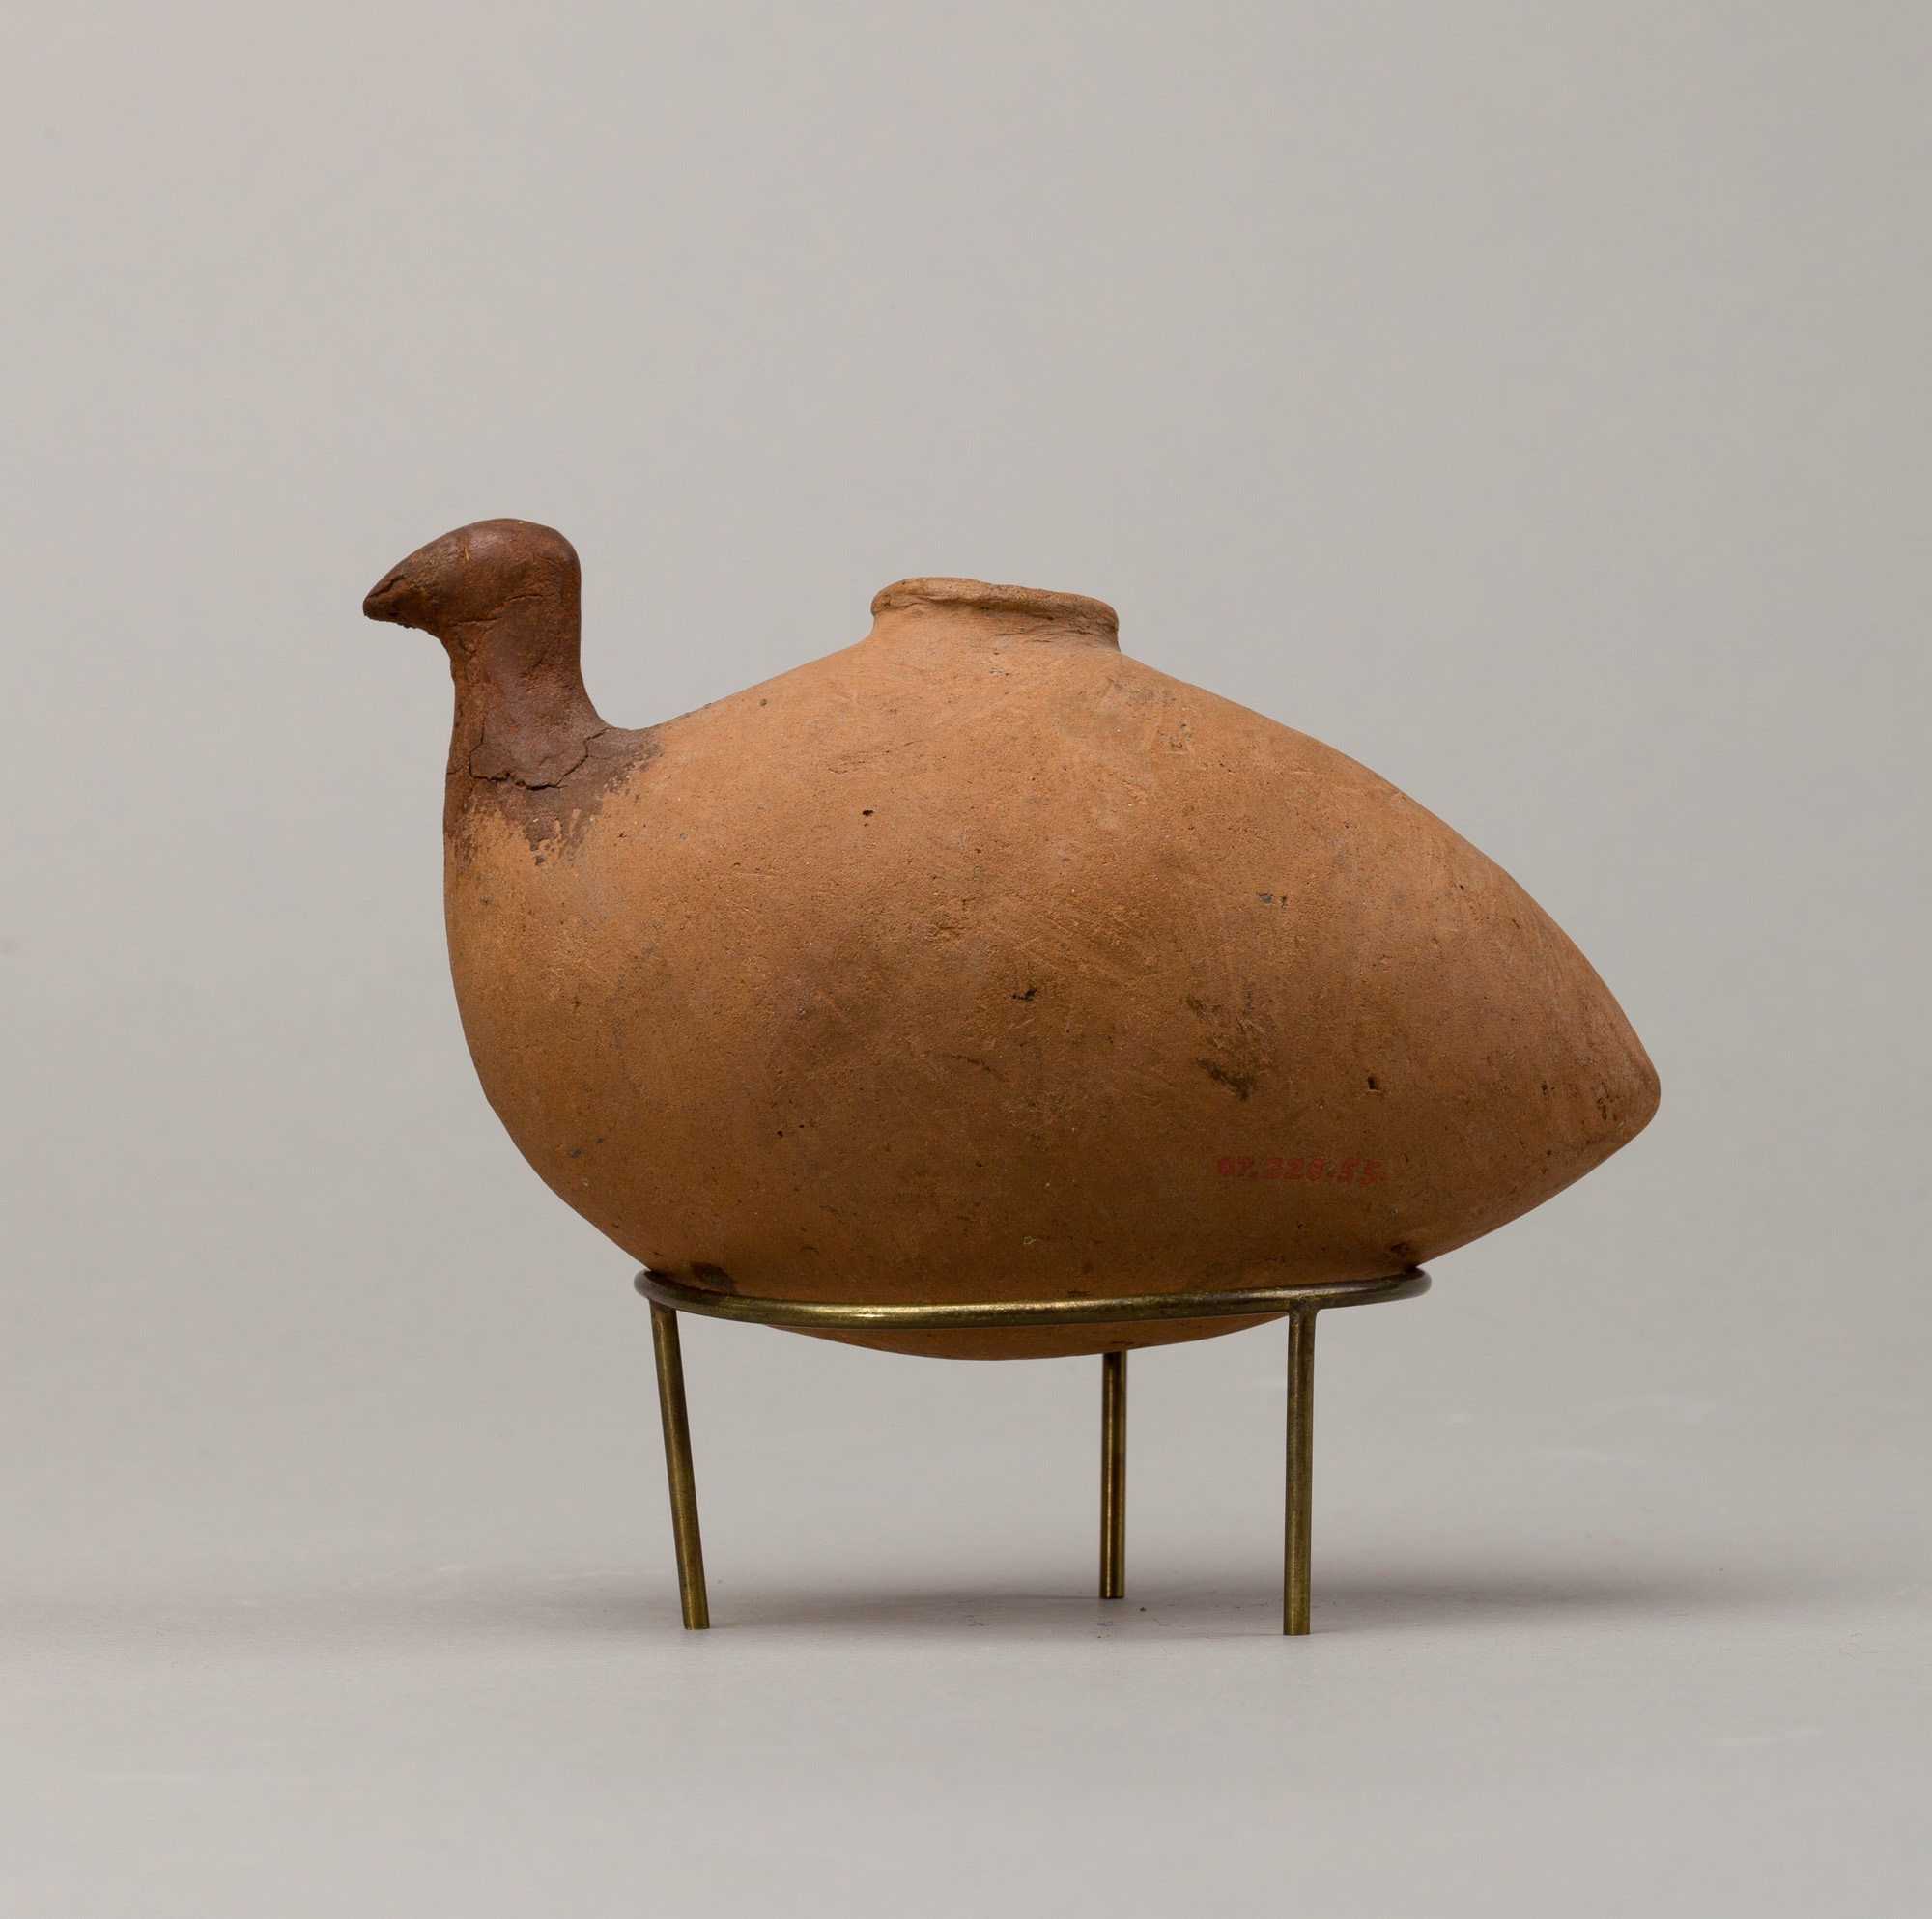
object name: vessel, bird shaped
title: Vessel in shape of bird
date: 4500-4000 BCE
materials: pottery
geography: egypt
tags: birds